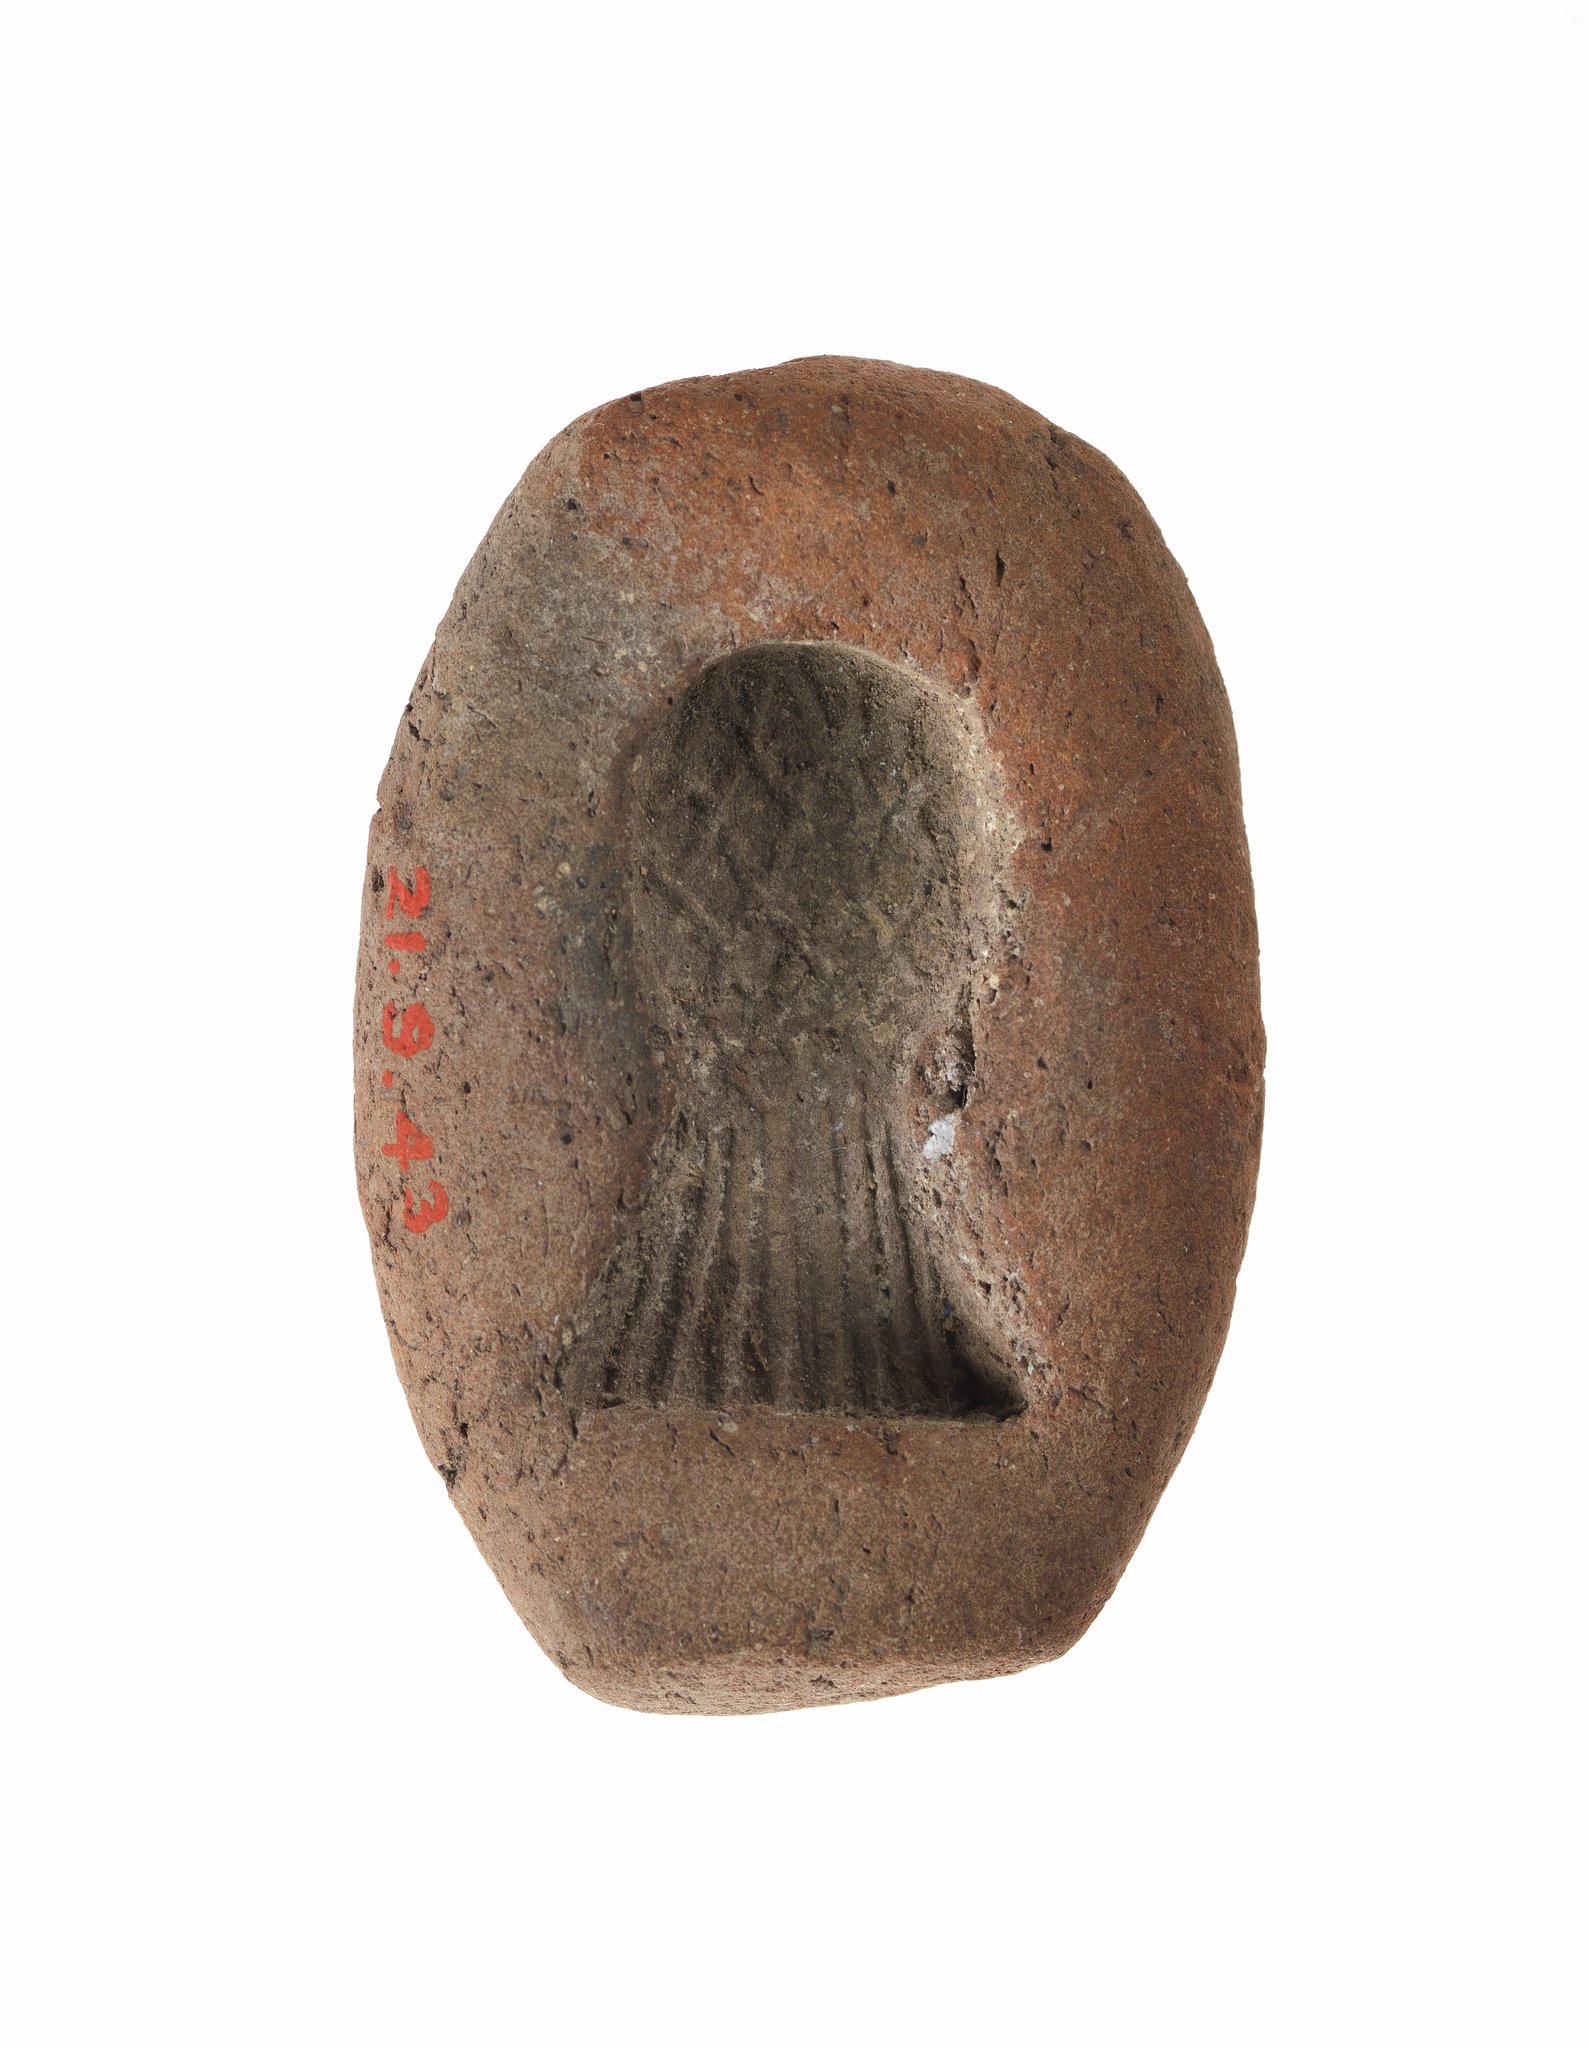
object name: mold, cornflower pendant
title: Mold for Cornflower Pendant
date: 1353-1336 BCE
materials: pottery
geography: egypt